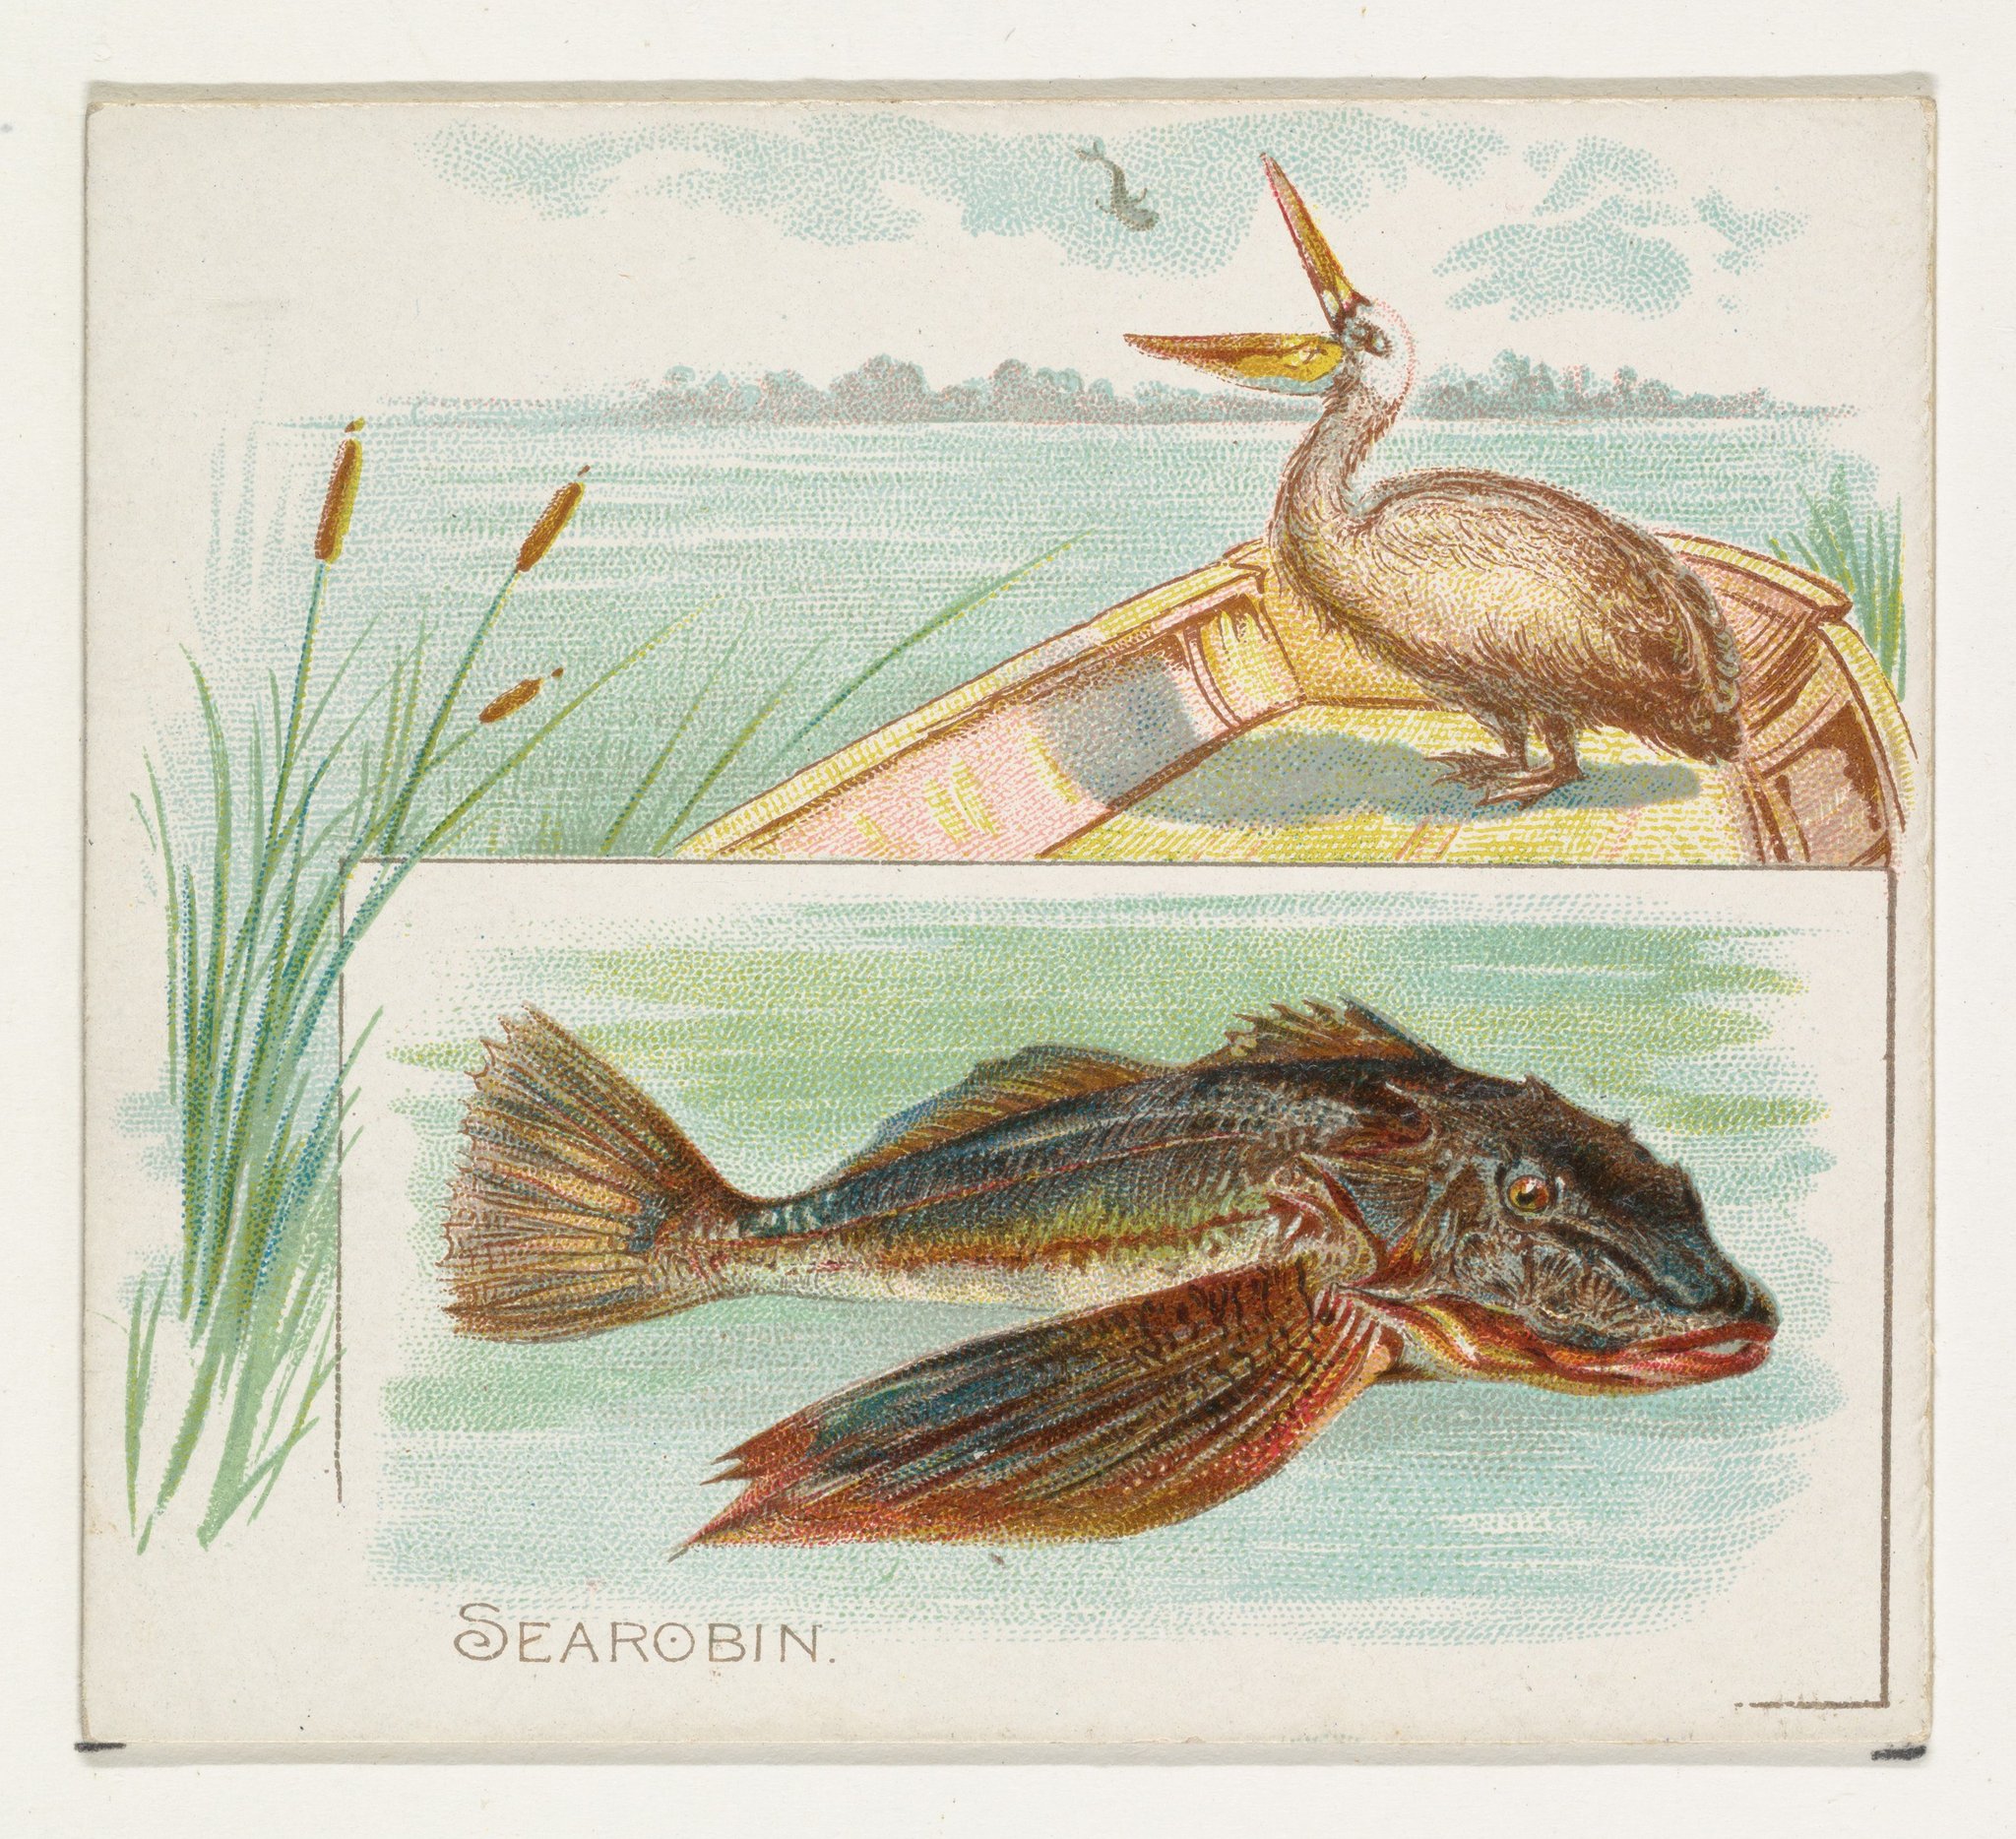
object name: print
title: Searobin, from Fish from American Waters series (N39) for Allen & Ginter Cigarettes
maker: allen & ginter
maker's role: publisher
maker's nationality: american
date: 1889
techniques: color lithograph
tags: birds,fish